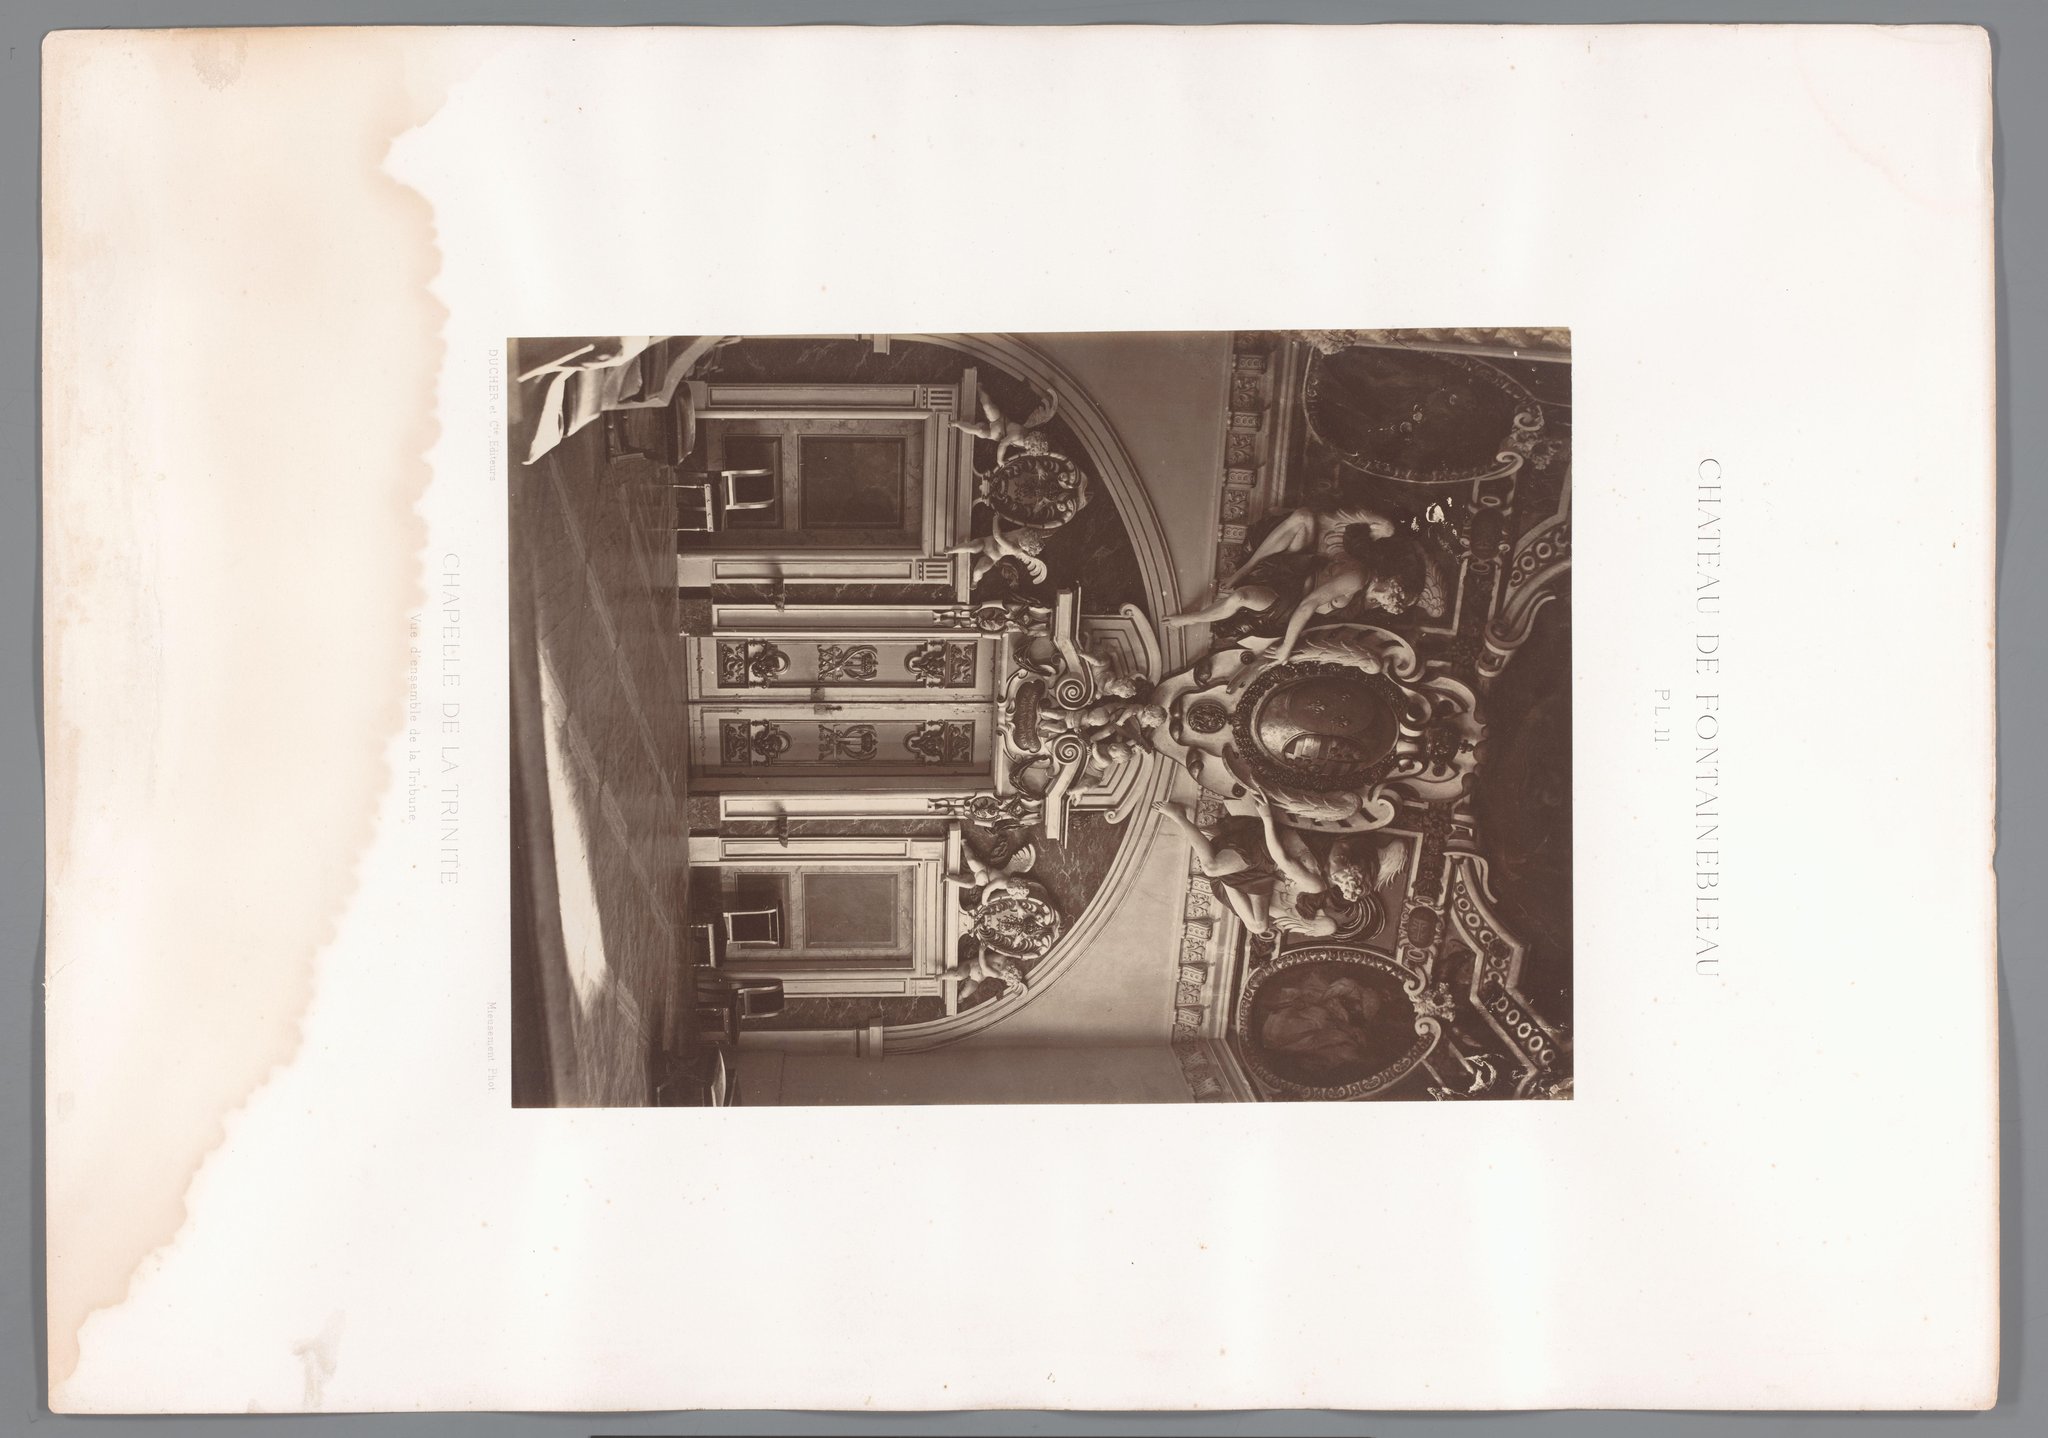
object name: photograph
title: Chapelle de la Trinité - Vue d'Ensemble de la Tribune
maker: séraphin-médéric mieusement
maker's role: fotograaf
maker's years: 1840-1905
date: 1870-1875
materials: photographic support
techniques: albumen print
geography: fontainebleau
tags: chapel (interior of the house), castle - aa - civic architecture: inside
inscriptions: number: ‘PL. 11.’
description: Deze foto maakt deel uit van een omslag met dertig foto's en twee tekstbladen.